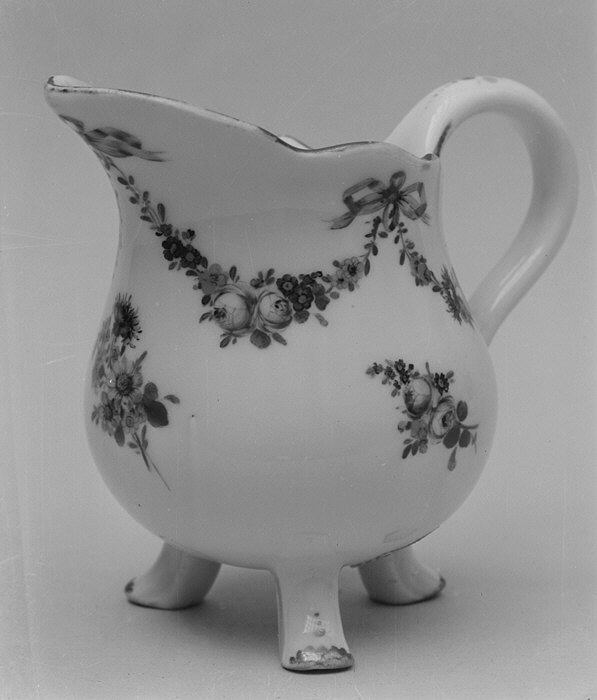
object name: cream jug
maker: gotha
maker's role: factory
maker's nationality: german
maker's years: 1757-1900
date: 1770-1780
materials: hard paste porcelain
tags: flowers